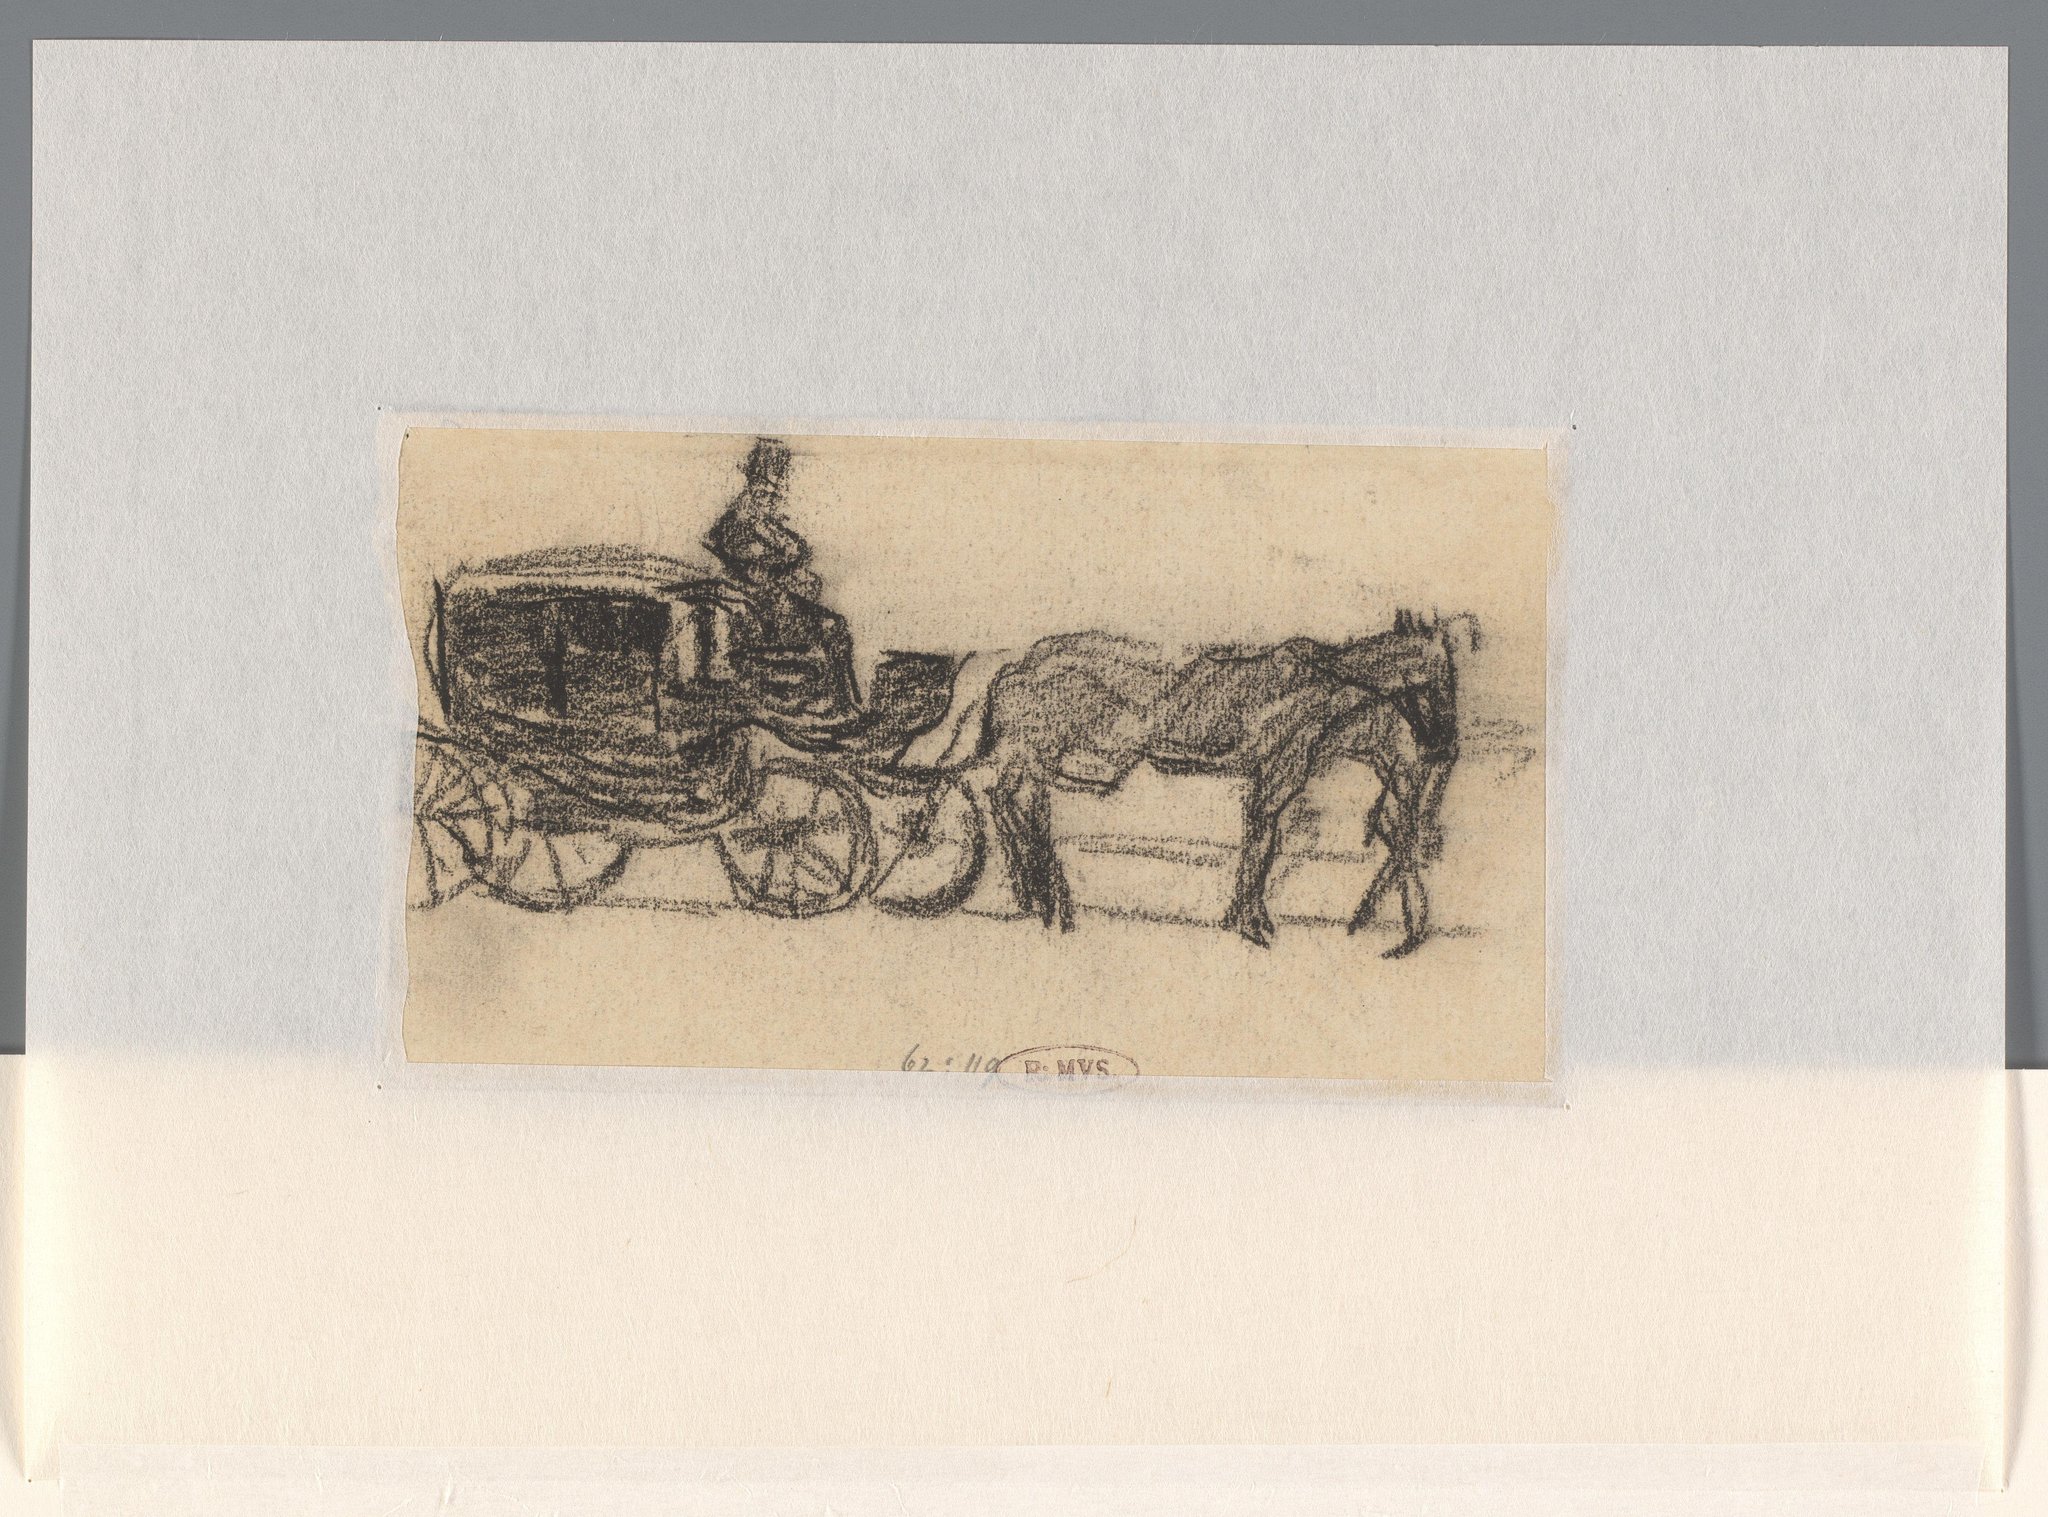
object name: drawing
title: Rijtuig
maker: jan veth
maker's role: designer, draughtsman, painter, print maker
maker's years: 1864-1925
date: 1888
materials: chalk, paper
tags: four-wheeled, animal-drawn vehicle, e.g.: cab, carriage, coach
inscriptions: date: ‘1888’